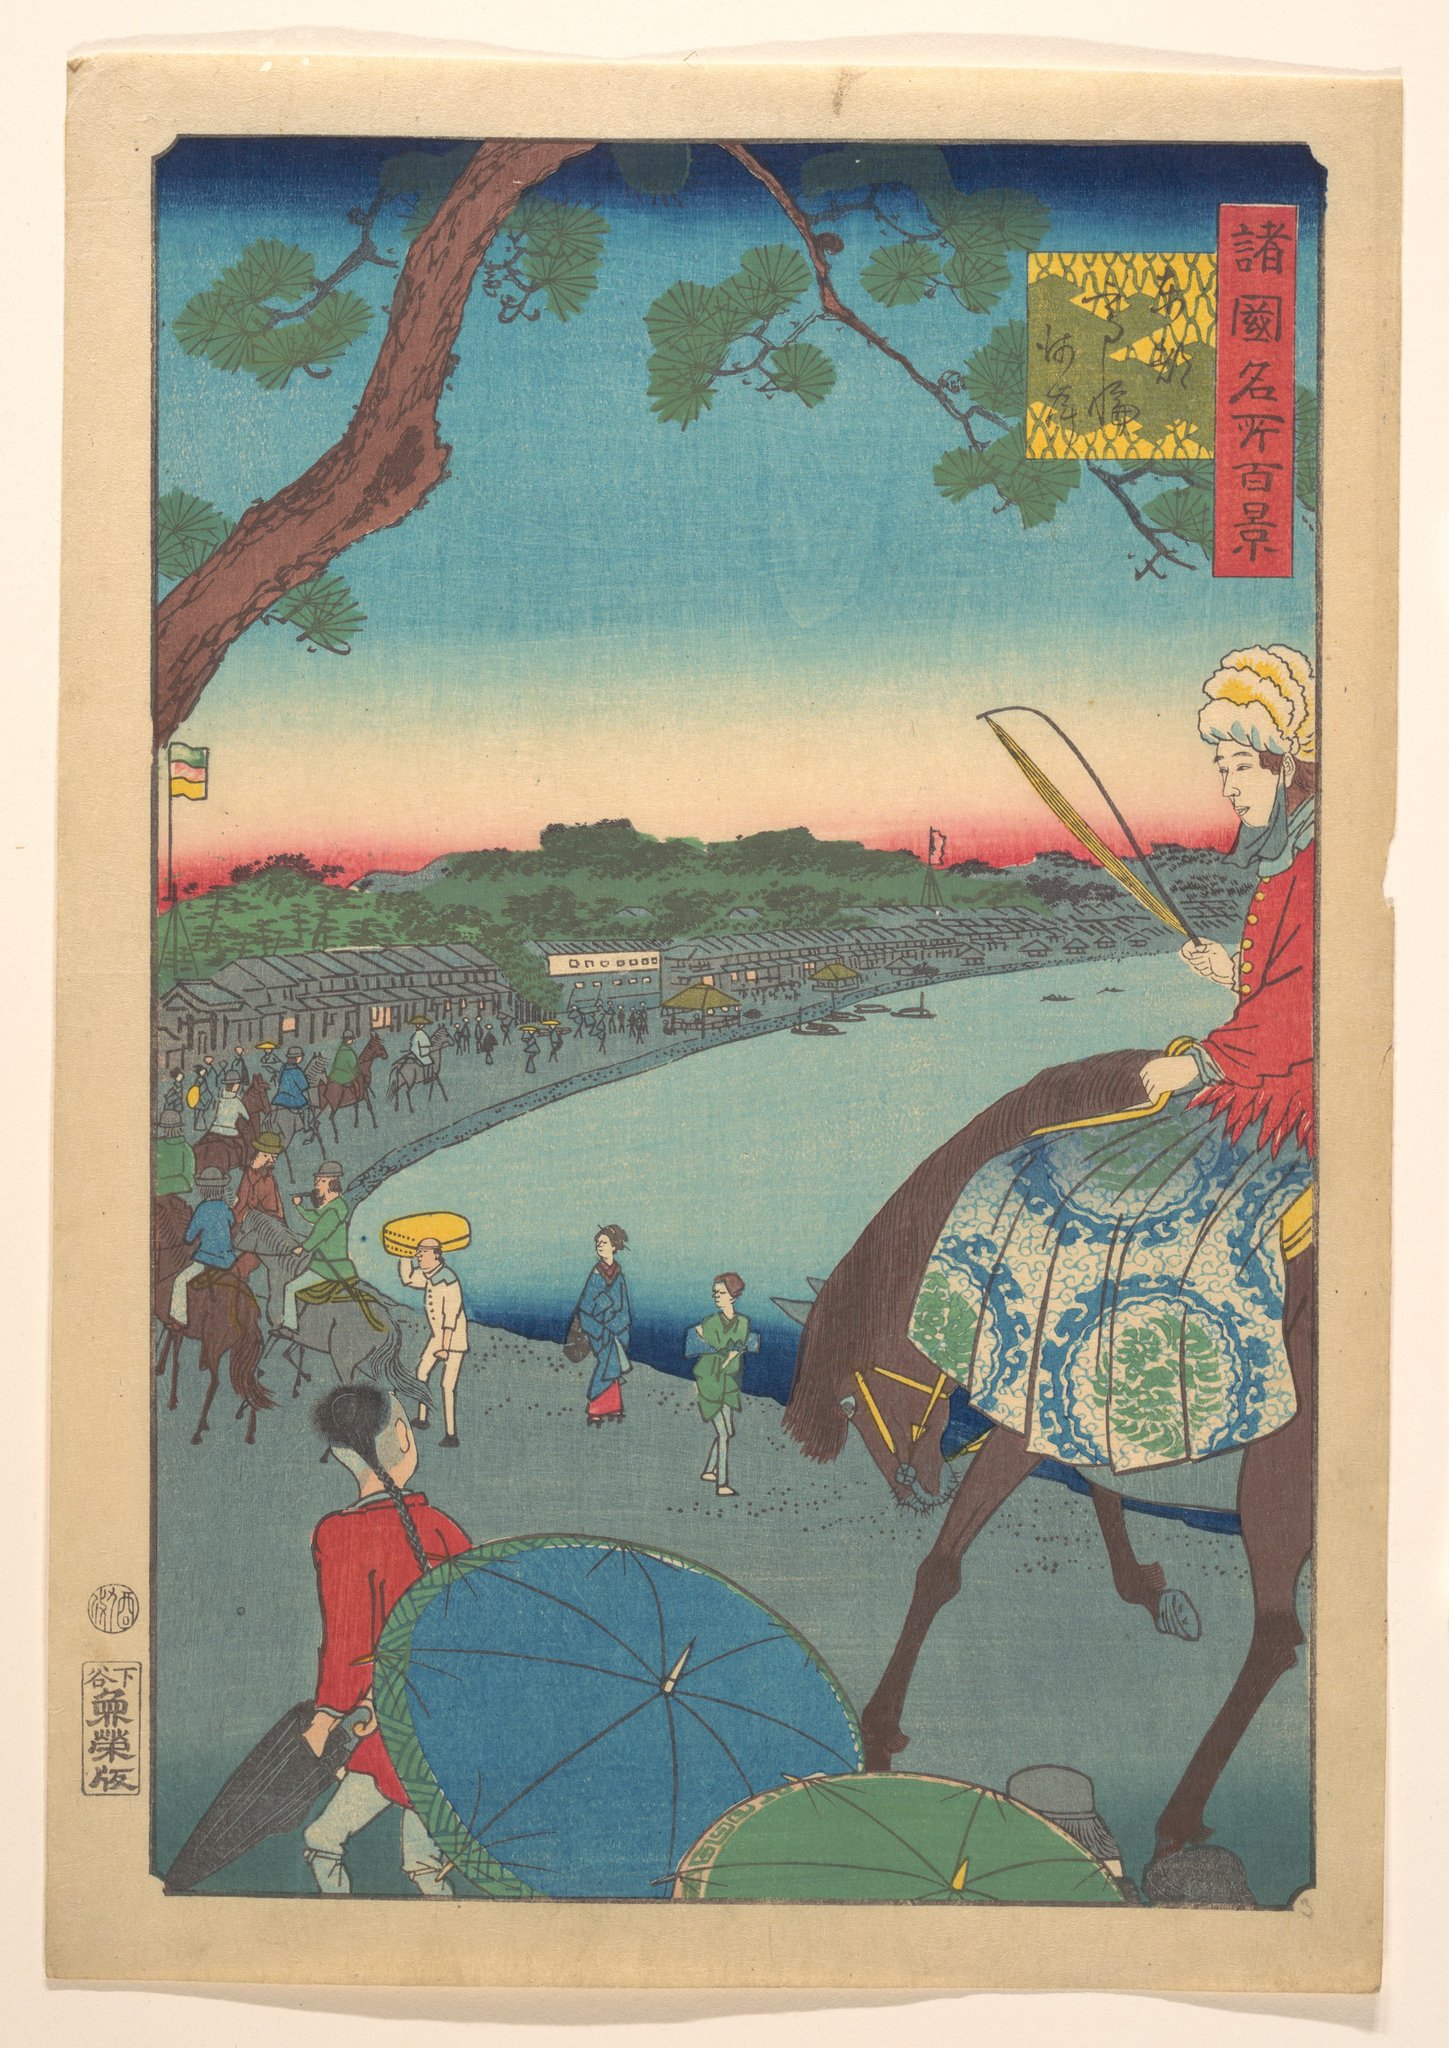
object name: print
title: Foreigners Riding Along the Coast at Takanawa in the Eastern Capital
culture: japanese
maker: utagawa hiroshige ii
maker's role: artist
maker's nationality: japanese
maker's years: 1826-1869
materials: ink, paper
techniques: woodblock print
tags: men,women,horses